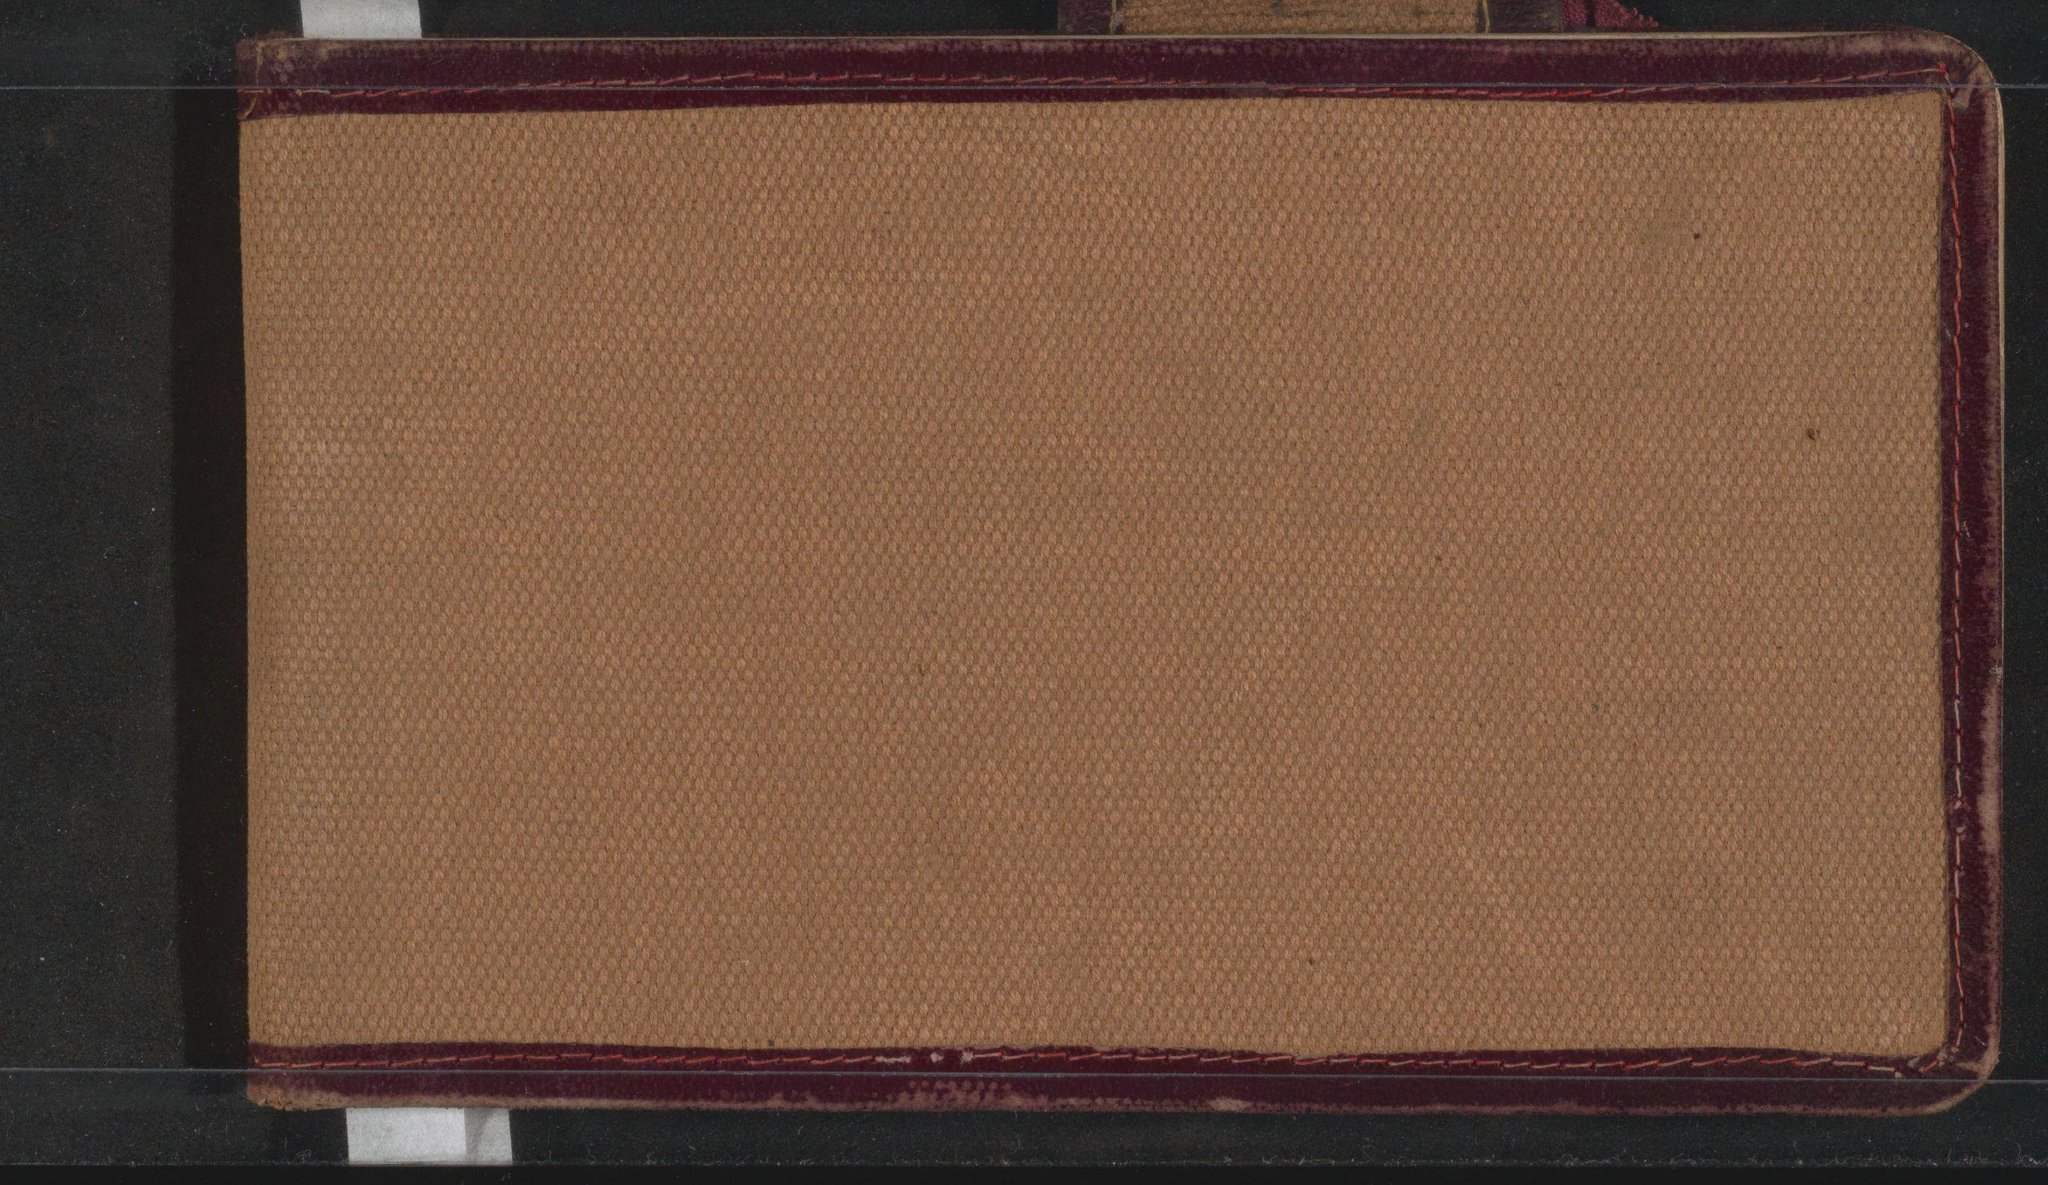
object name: sketchbook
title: Schetsboek met 34 bladen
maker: johan antonie de jonge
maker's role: draughtsman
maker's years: 1864-1927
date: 1881-1927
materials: chalk, leather, linen, paper, pencil, watercolor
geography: south holland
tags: dune coast, factories and mills in landscape, sheep, coast, farm or solitary house in landscape, water-birds: duck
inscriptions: collector's mark: Lugt 2228, retailer's mark: ‘W.M. Stam/ Schilder- en/ Teekenbehoeften/ Papestraat 15/ Den Haag’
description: Schetsboek bestaande uit 34 bladen met duinlandschappen, figuurstudies en dierstudies.